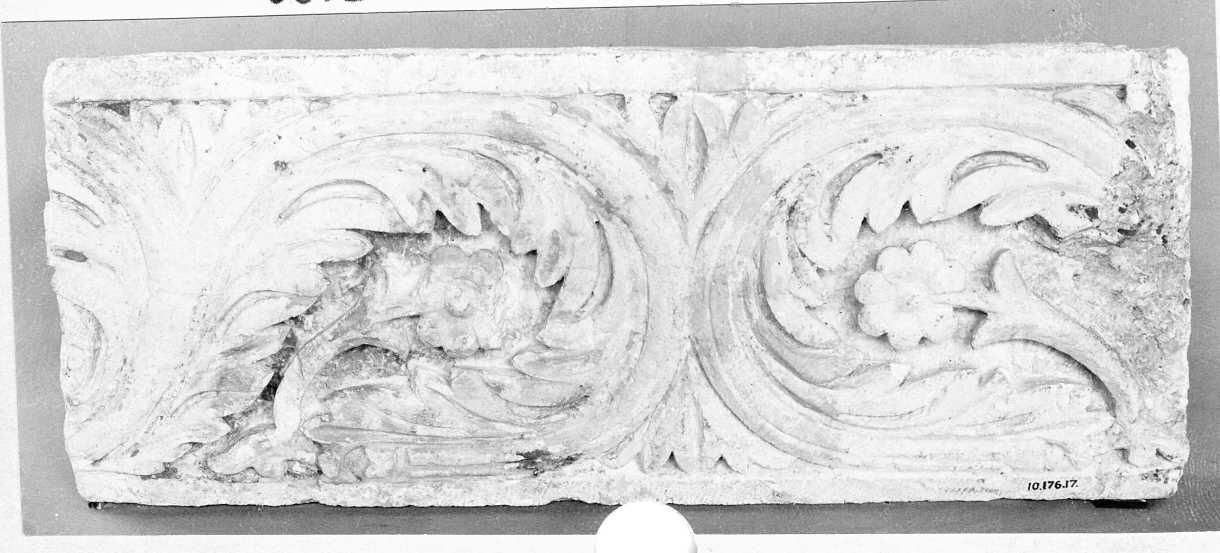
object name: fragment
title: Fragment of a Frieze with Acanthus Scrolls, Palmettes, and Flowers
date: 301-500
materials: limestone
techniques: carving, relief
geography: egypt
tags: palmettes,flowers